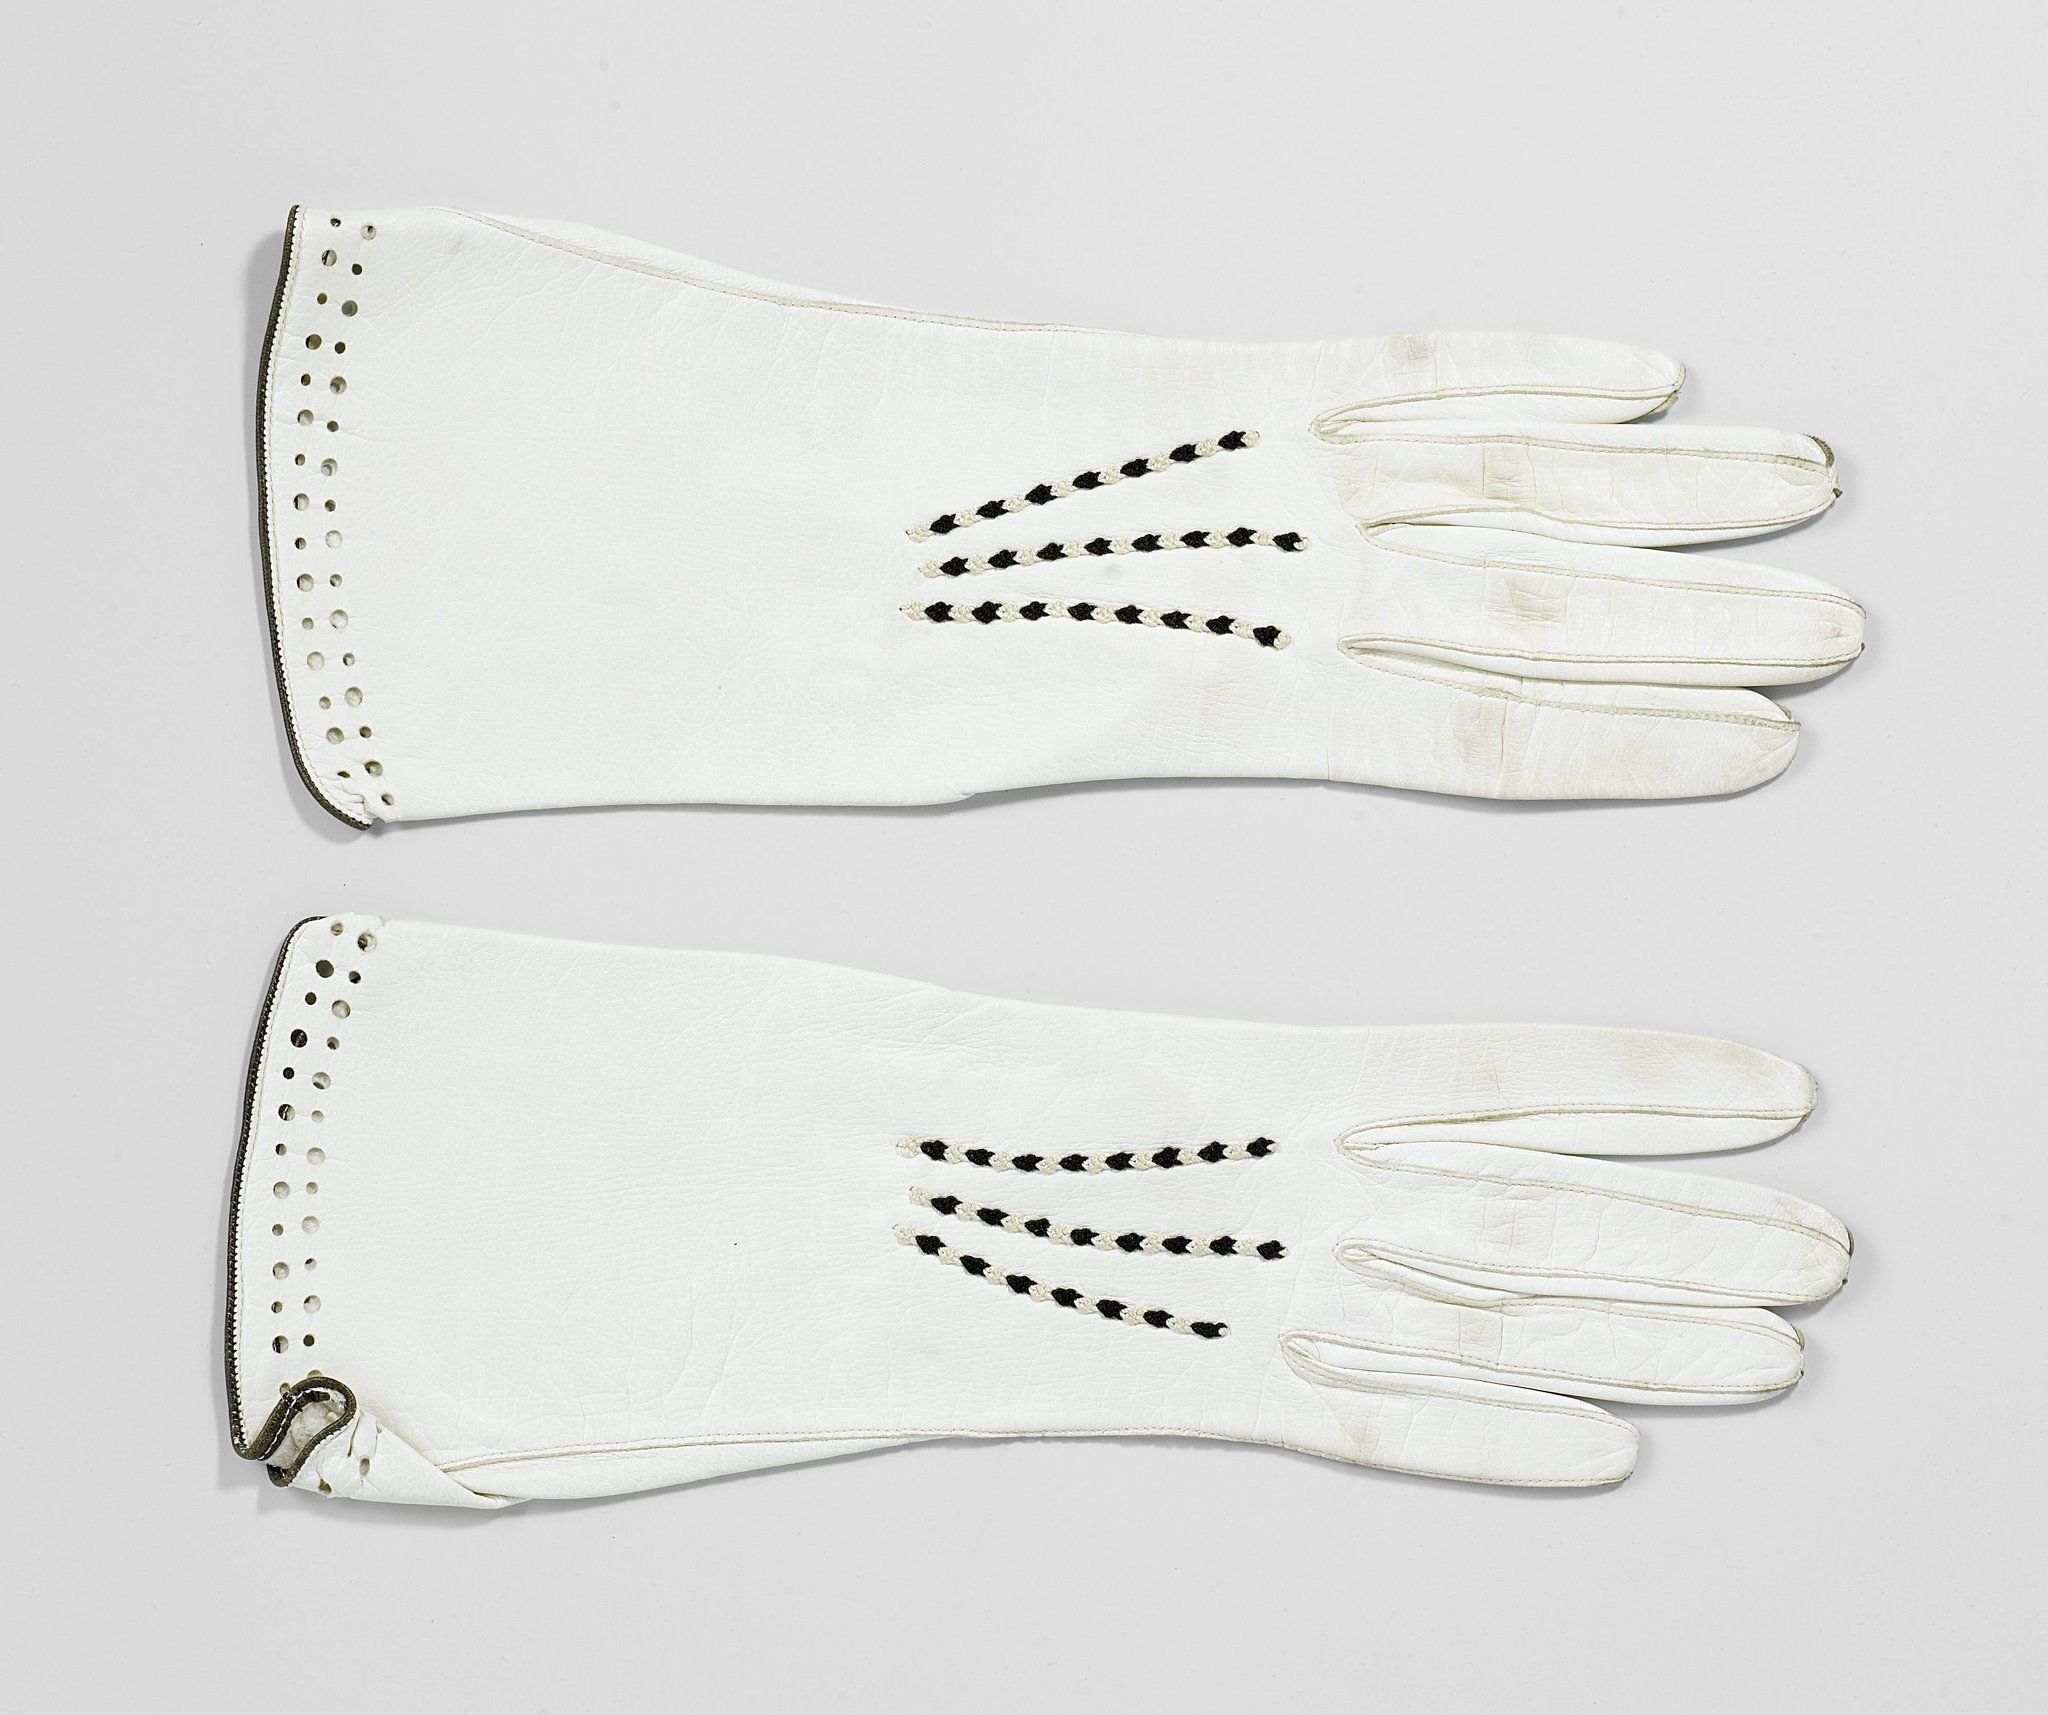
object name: clothing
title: Pair of gloves with embroidered seams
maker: m. laimböck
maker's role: modehuis, modewarenhuis, modewinkel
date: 1927-1930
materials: leather, silk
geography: amsterdam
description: Handschoen, van een paar (A en B), van wit, zwart gebiesd glacé-leer (pasgeborengeitenleer). Model: halflang, pasnaadjes geborduurd met witte en zwarte zijde. De uiteinden zijn geperforeerd en zwart gebiesd. Adres: op linker ex.: paars stempel van gekroonde adelaar met banderol waarop M.LAIMBOCK/UIT TIROL/AMSTERDAM/K.HOFLEVERANCIER. Verder: Charaux garanti. Op rechterhandschoen: INGOWA. Oostenrijk, Tirol, voor fa. Laimböck te Amsterdam, ca. 1927-1930.